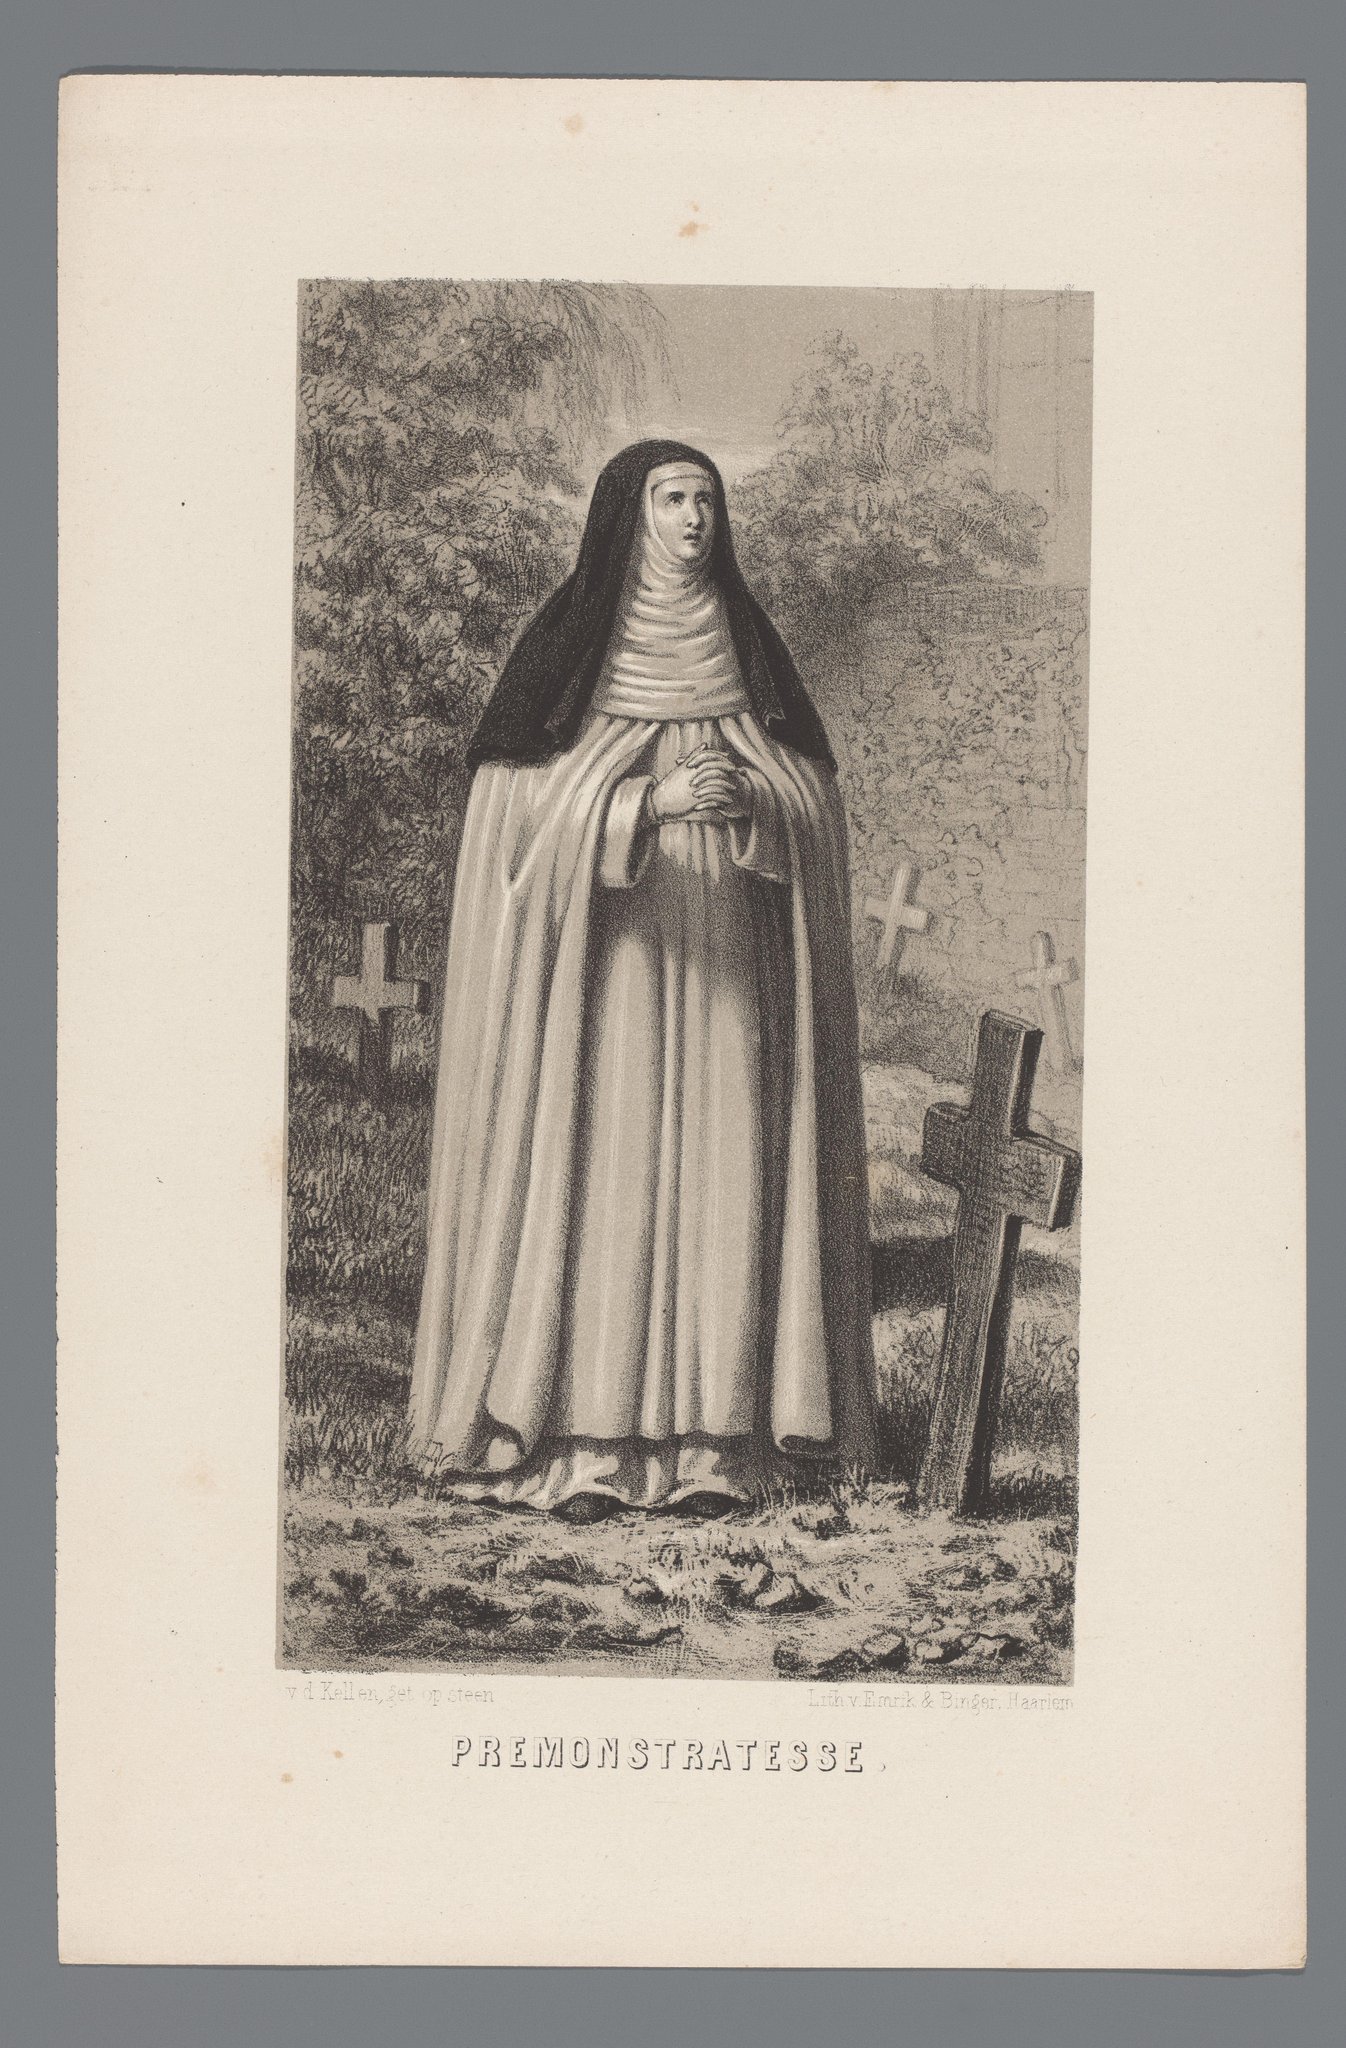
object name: book illustration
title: Premonstratenzer non biddend op een begraafplaats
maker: david van der kellen (1827-1895)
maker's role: draughtsman, print maker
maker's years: 1827-1895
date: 1865-1874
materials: paper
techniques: tone lithography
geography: the hague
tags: nun(s), churchyard, cemetery, one person praying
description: Prent waarschijnlijk uit: Hofdijk, W.J. De klooster-orden in Nederland. Haarlem: A.C. Kruseman, 1865. Of uit de editie van 1874.